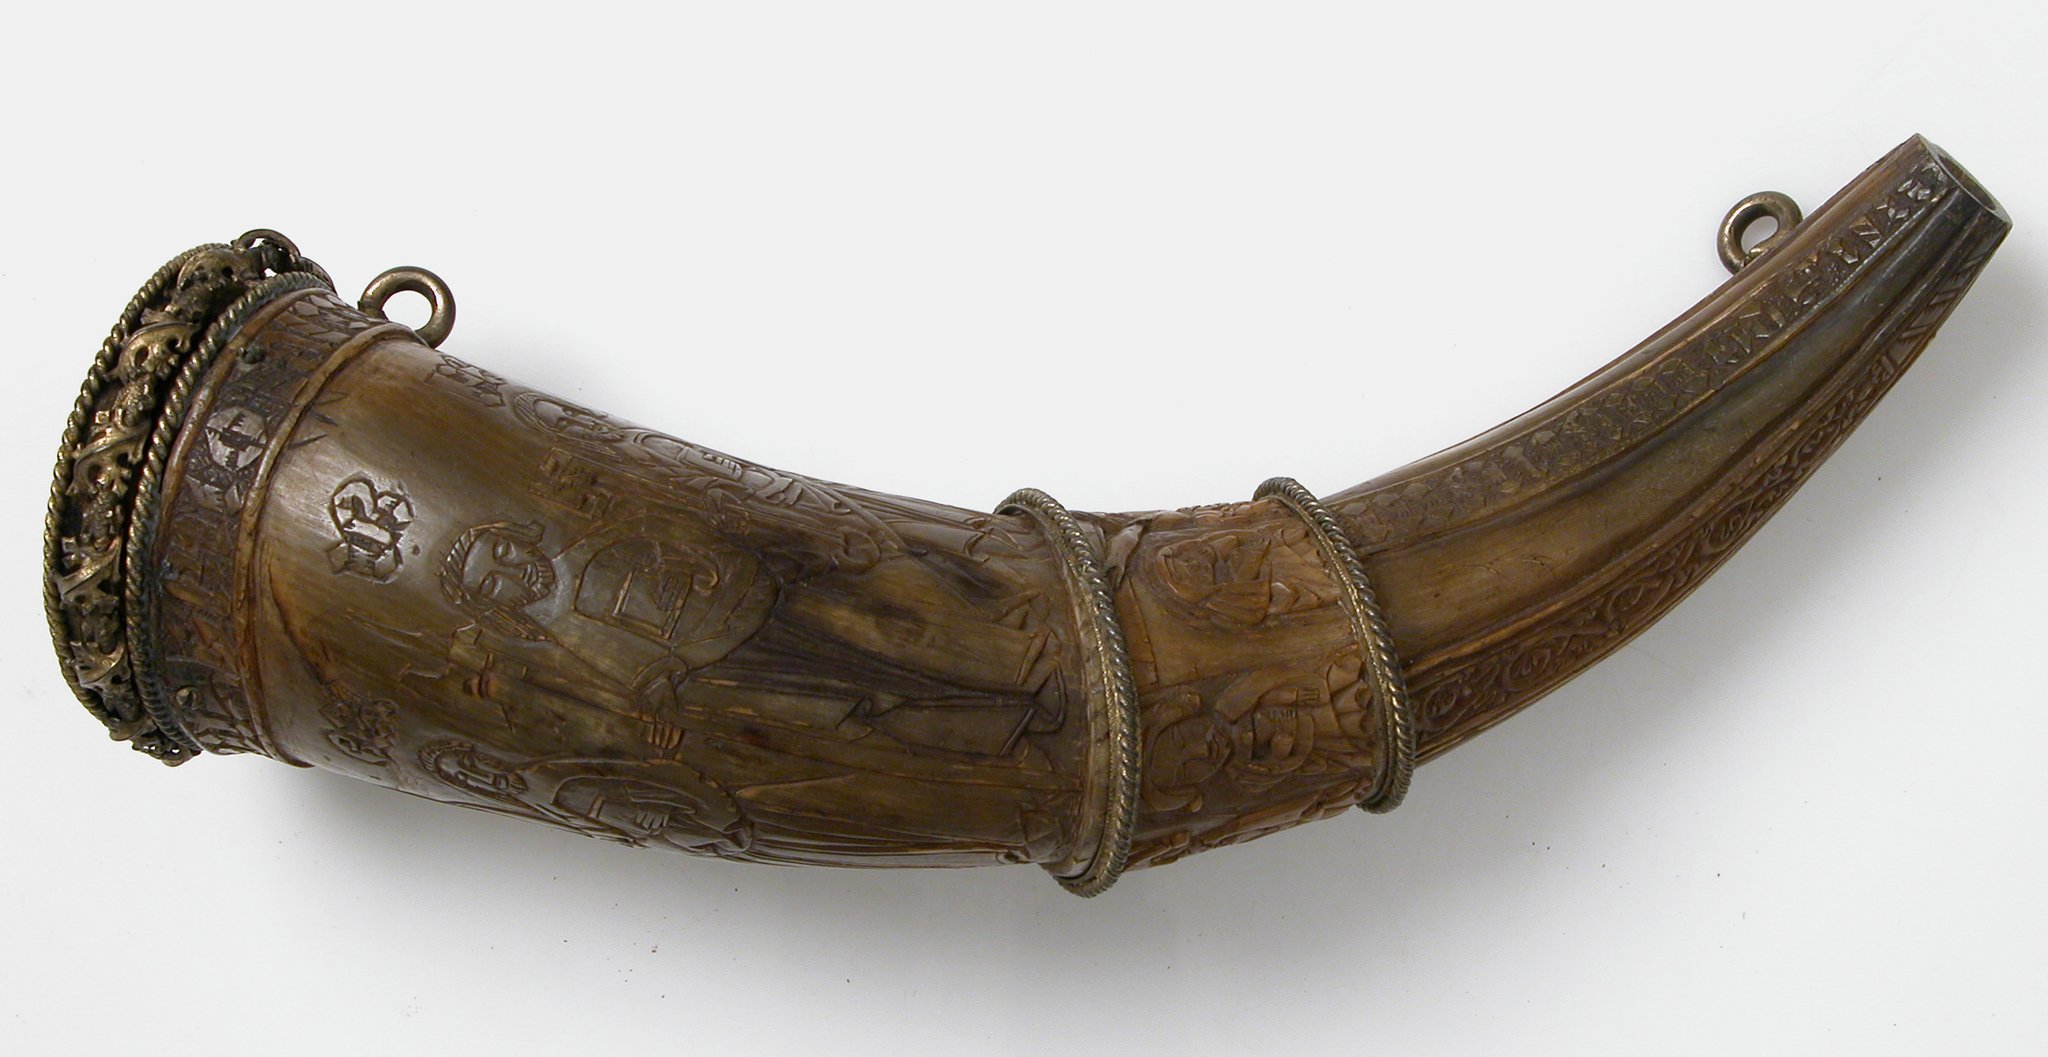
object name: hunting horn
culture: french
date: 1401-1500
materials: horn, silver gilt